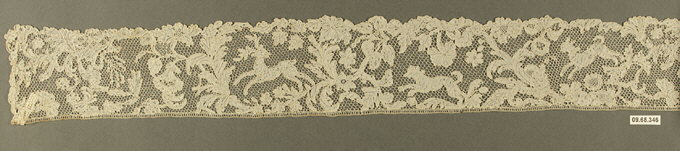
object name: strip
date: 1701-1800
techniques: lace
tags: animals,deer,flowers